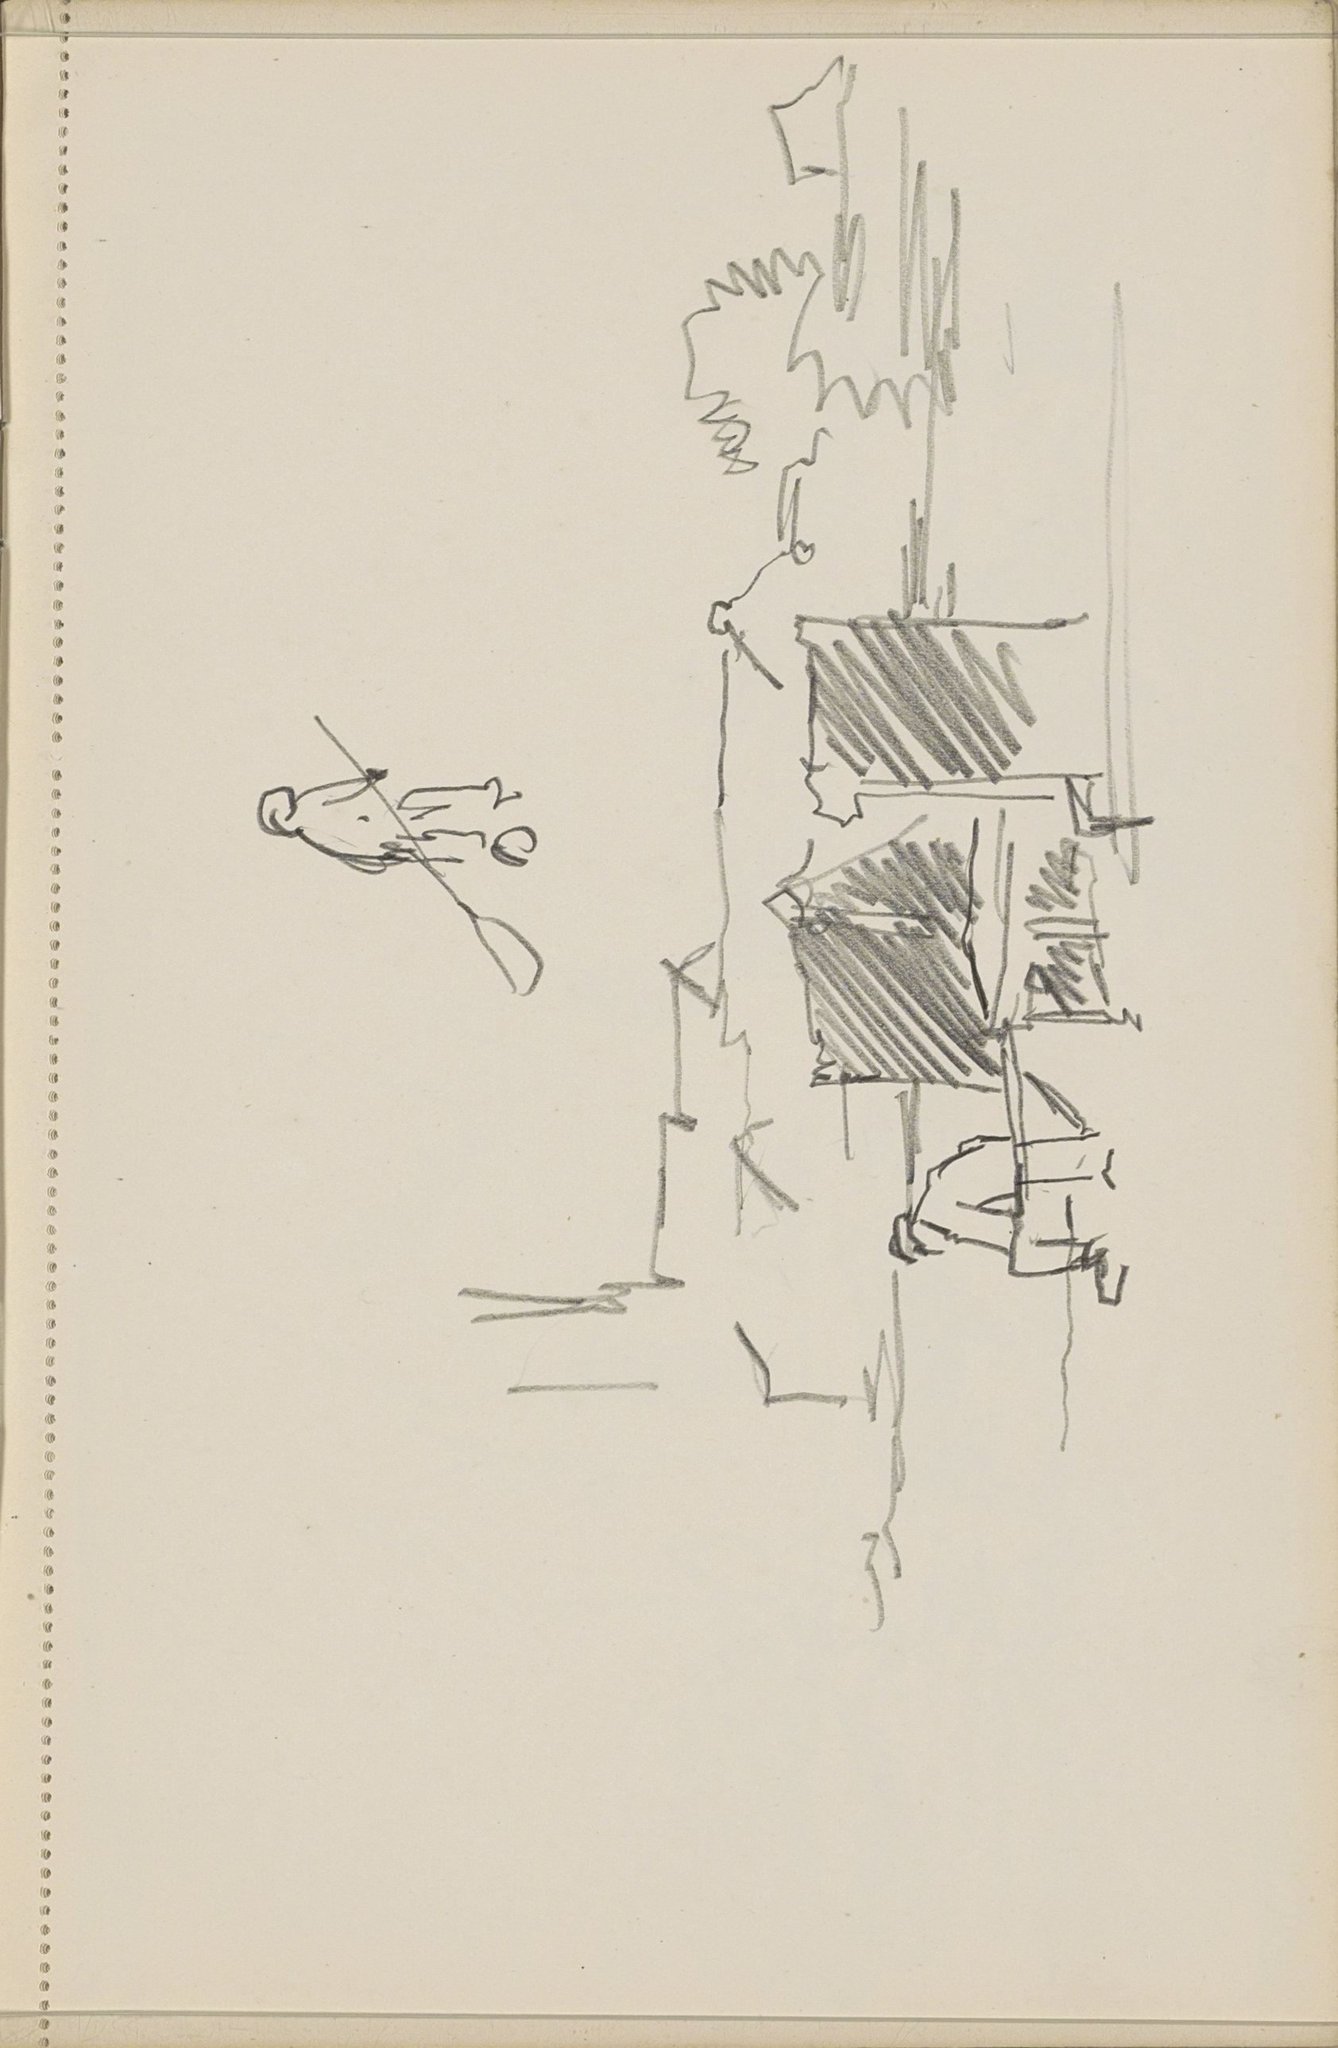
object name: sketchbook leaf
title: Zittende man aan een waterkant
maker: cornelis vreedenburgh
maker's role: draughtsman, print maker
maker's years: 1880-1946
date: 1890-1946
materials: paper, pencil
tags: city-view, and landscape with man-made constructions (+ city(-scape) with figures, staffage)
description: Blad 20 recto uit een schetsboek met 59 bladen.